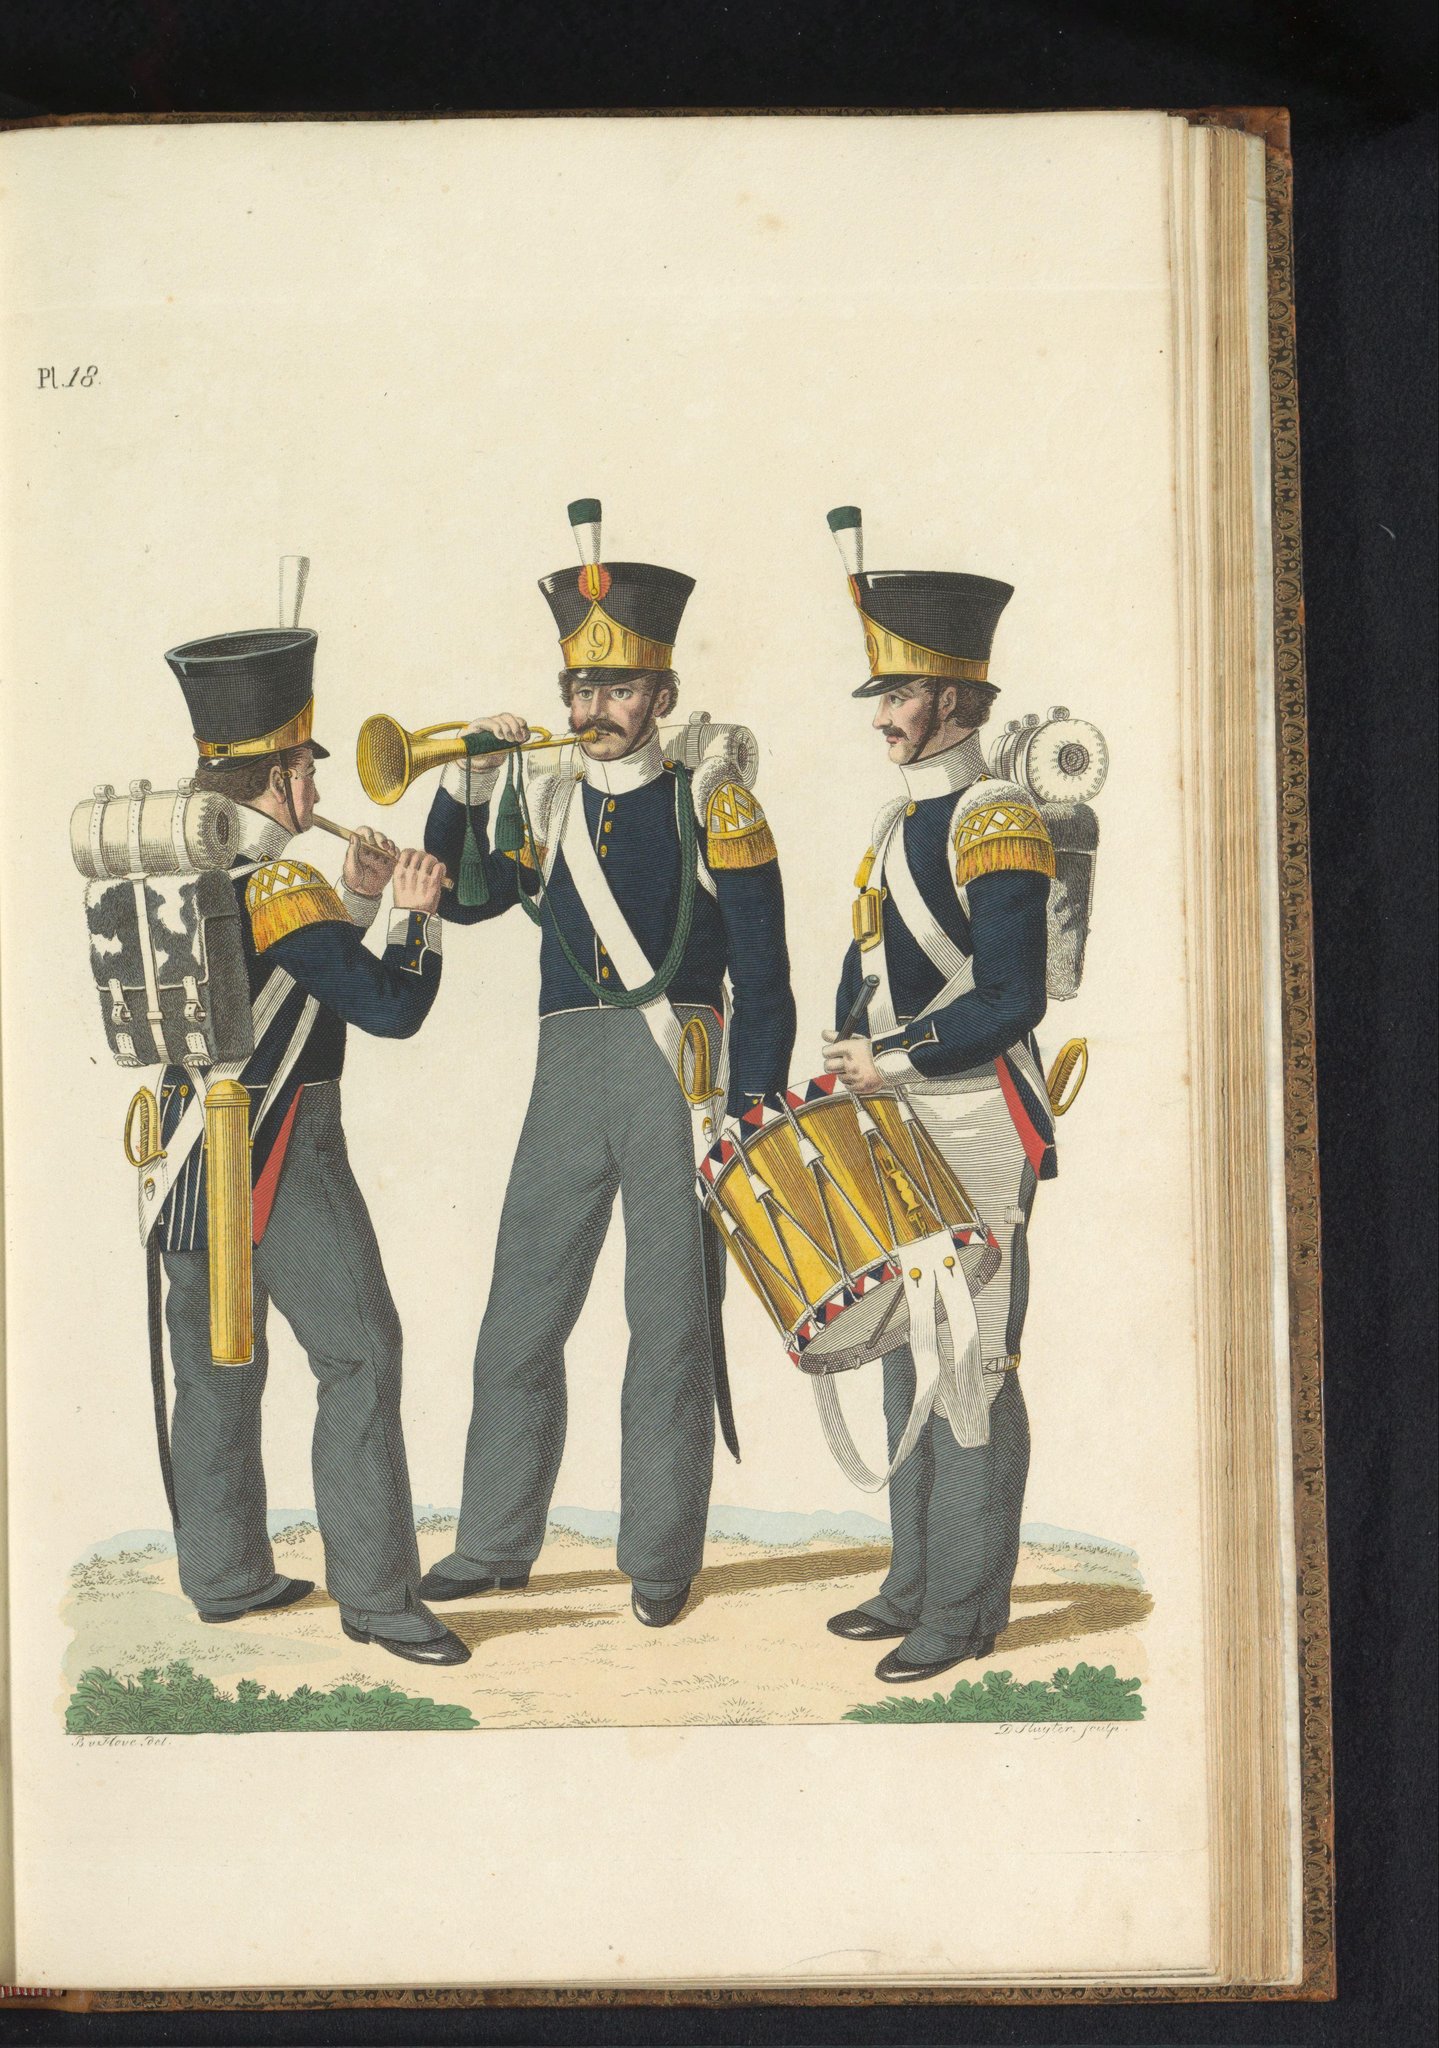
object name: print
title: Tamboer, Pijper en Hoornblazer, der Nationale Infanterie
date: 1823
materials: paper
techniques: engraving, etching, hand coloring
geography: netherlands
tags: military band, (military) uniforms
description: Een Nederlandse tamboer, een pijper en een hoornblazer van een muziekkorps van het 9e Regiment van de Nationale Infanterie. Plaat 18. Uniformvoorstelling in 'Beschrijving hoedanig de Koninklijke Nederlandsche troepen' van J.F. Teupken, 1823.